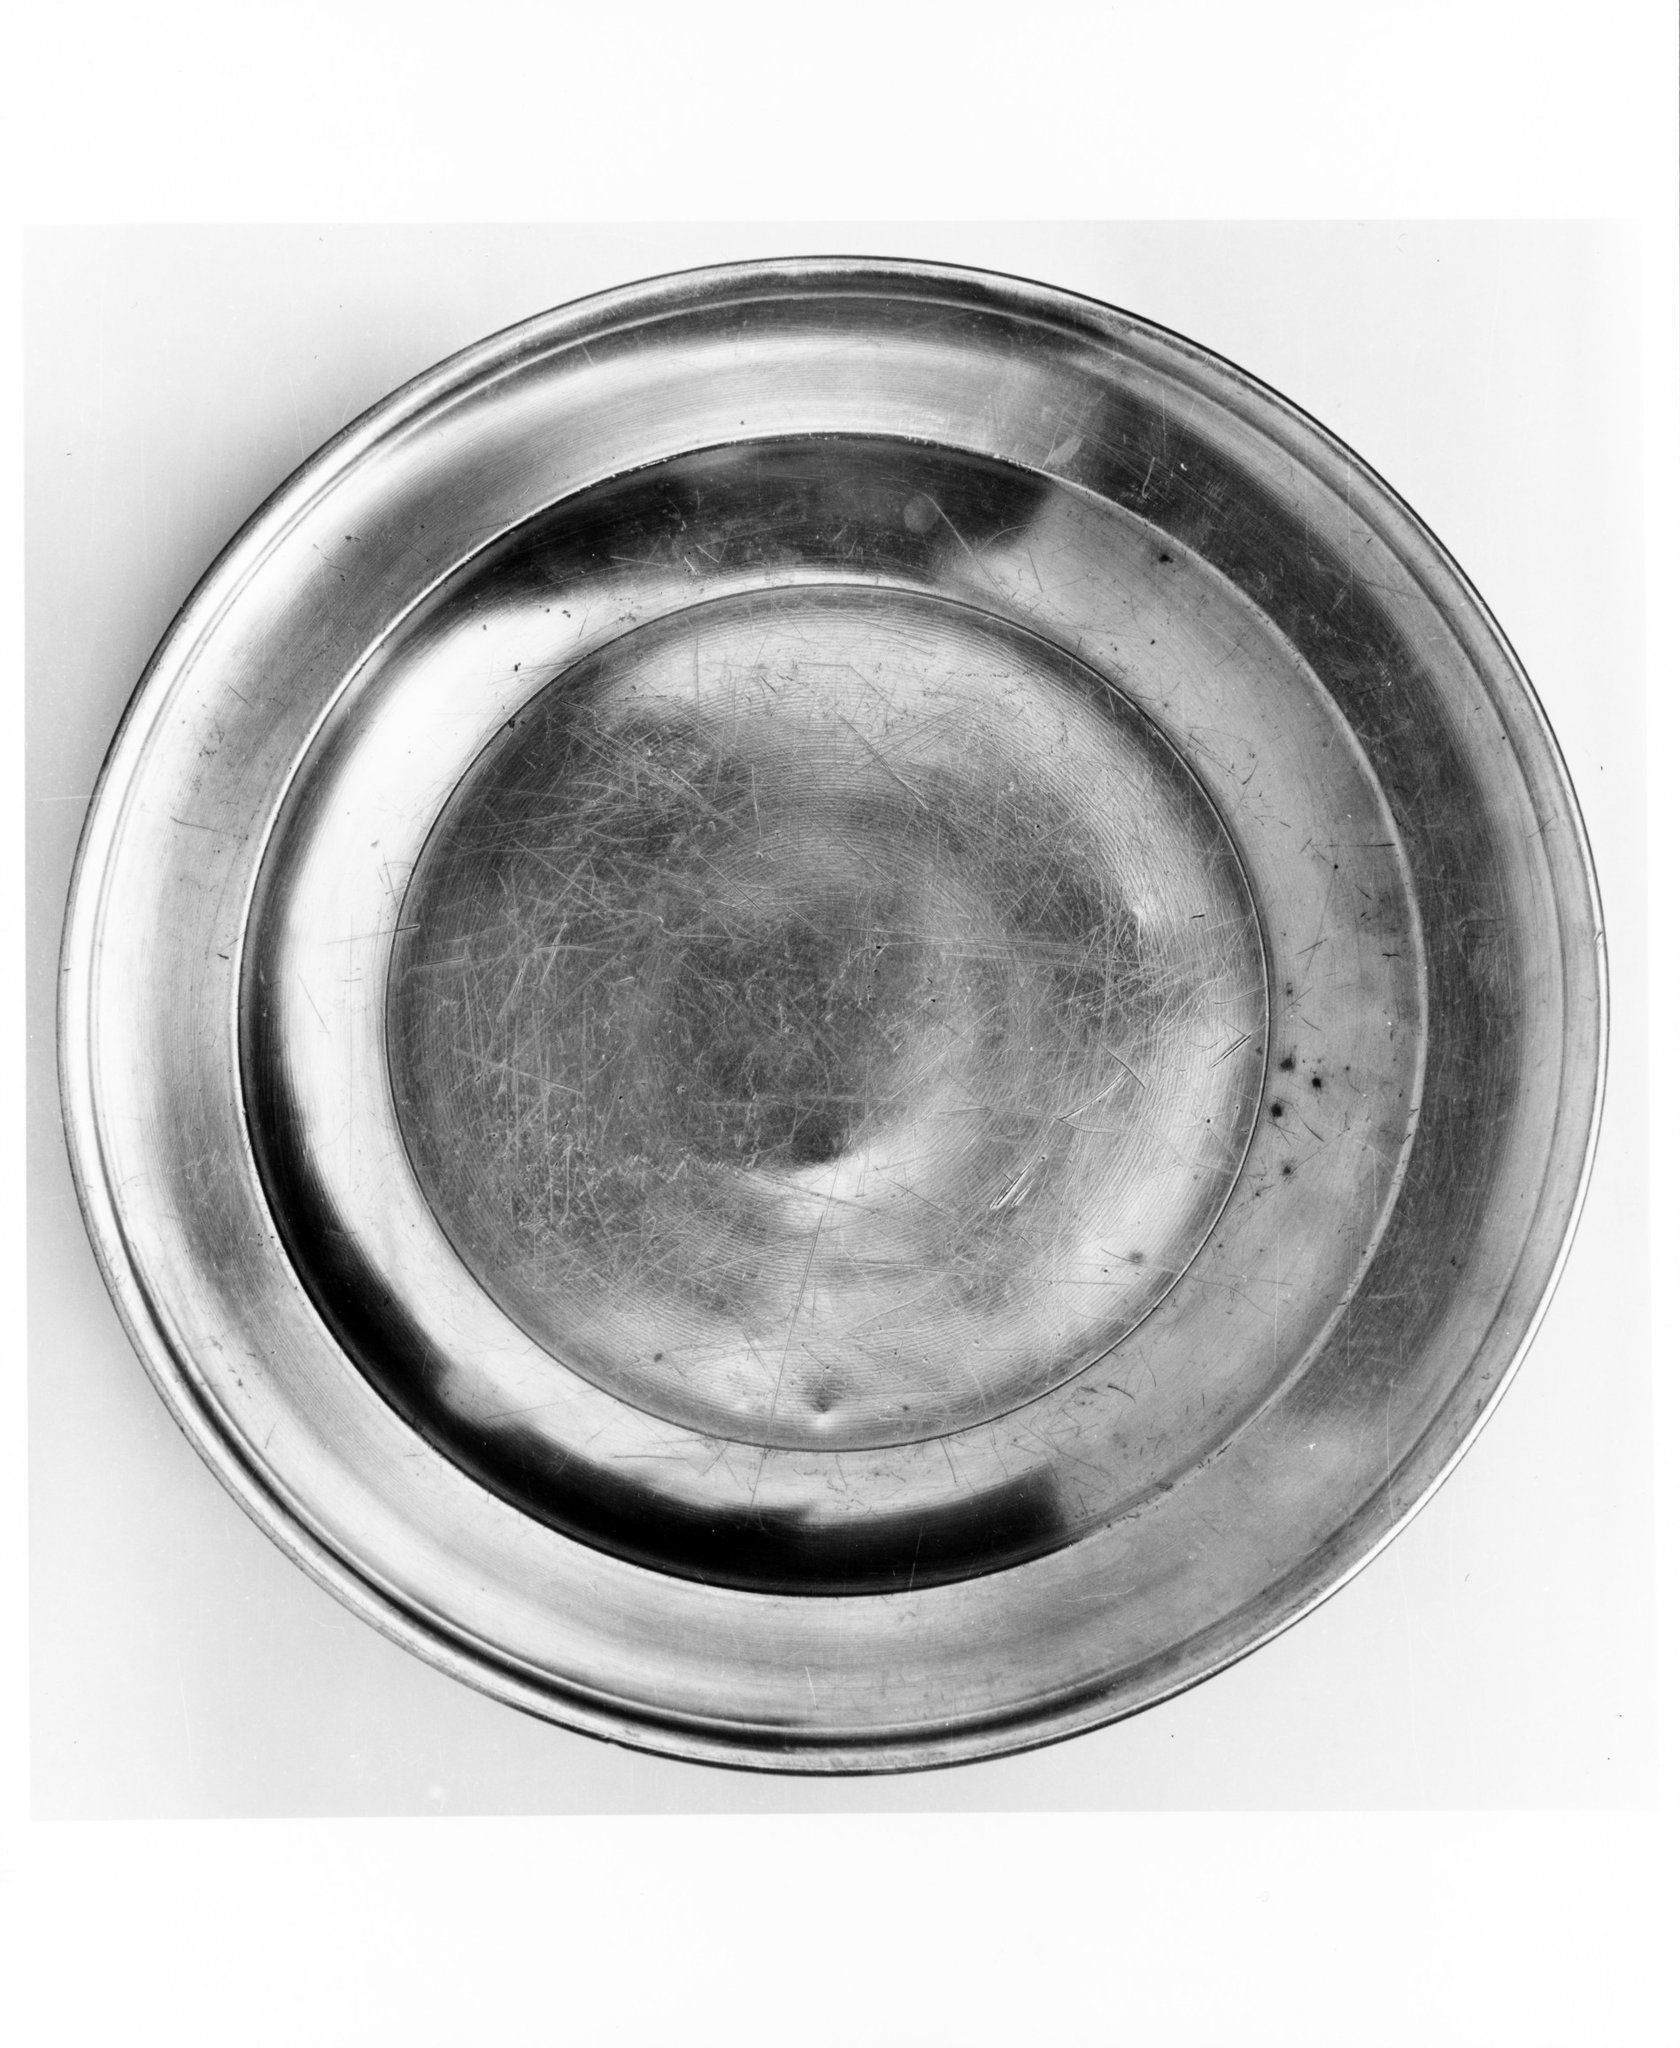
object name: dish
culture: american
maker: william will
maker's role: maker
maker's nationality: american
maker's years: 1742-1798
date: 1764-1798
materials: pewter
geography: united states